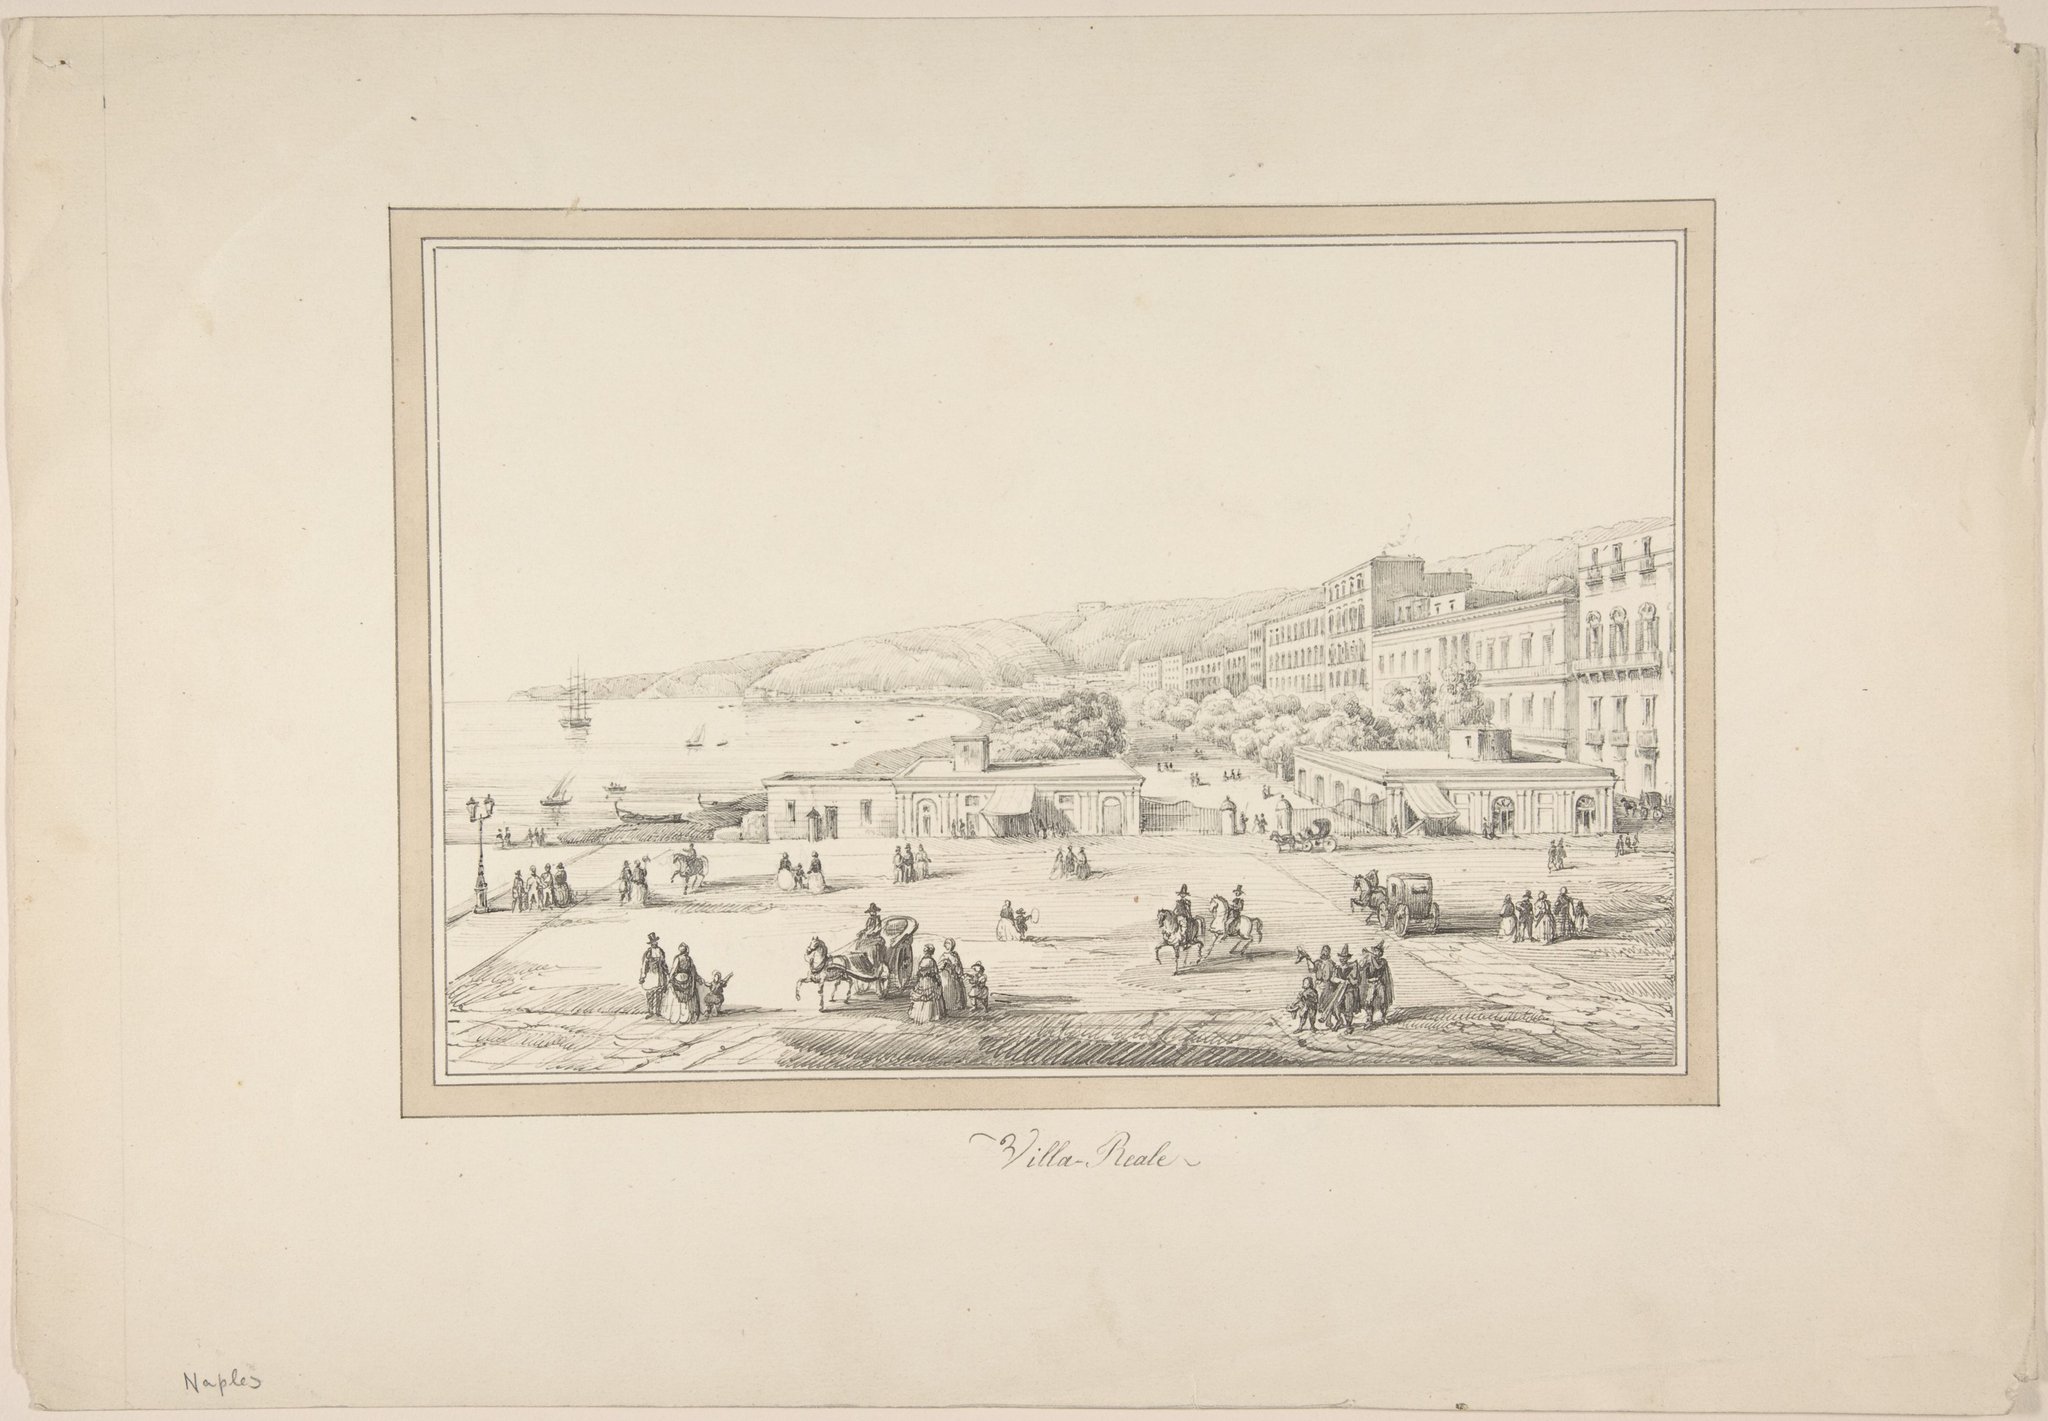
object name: drawing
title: View of Naples: Villa Reale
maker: anonymous, french, 19th century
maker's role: artist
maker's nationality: french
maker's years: 1800-1900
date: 1801-1900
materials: ink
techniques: brush, pen, wash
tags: human figures,buildings,horses